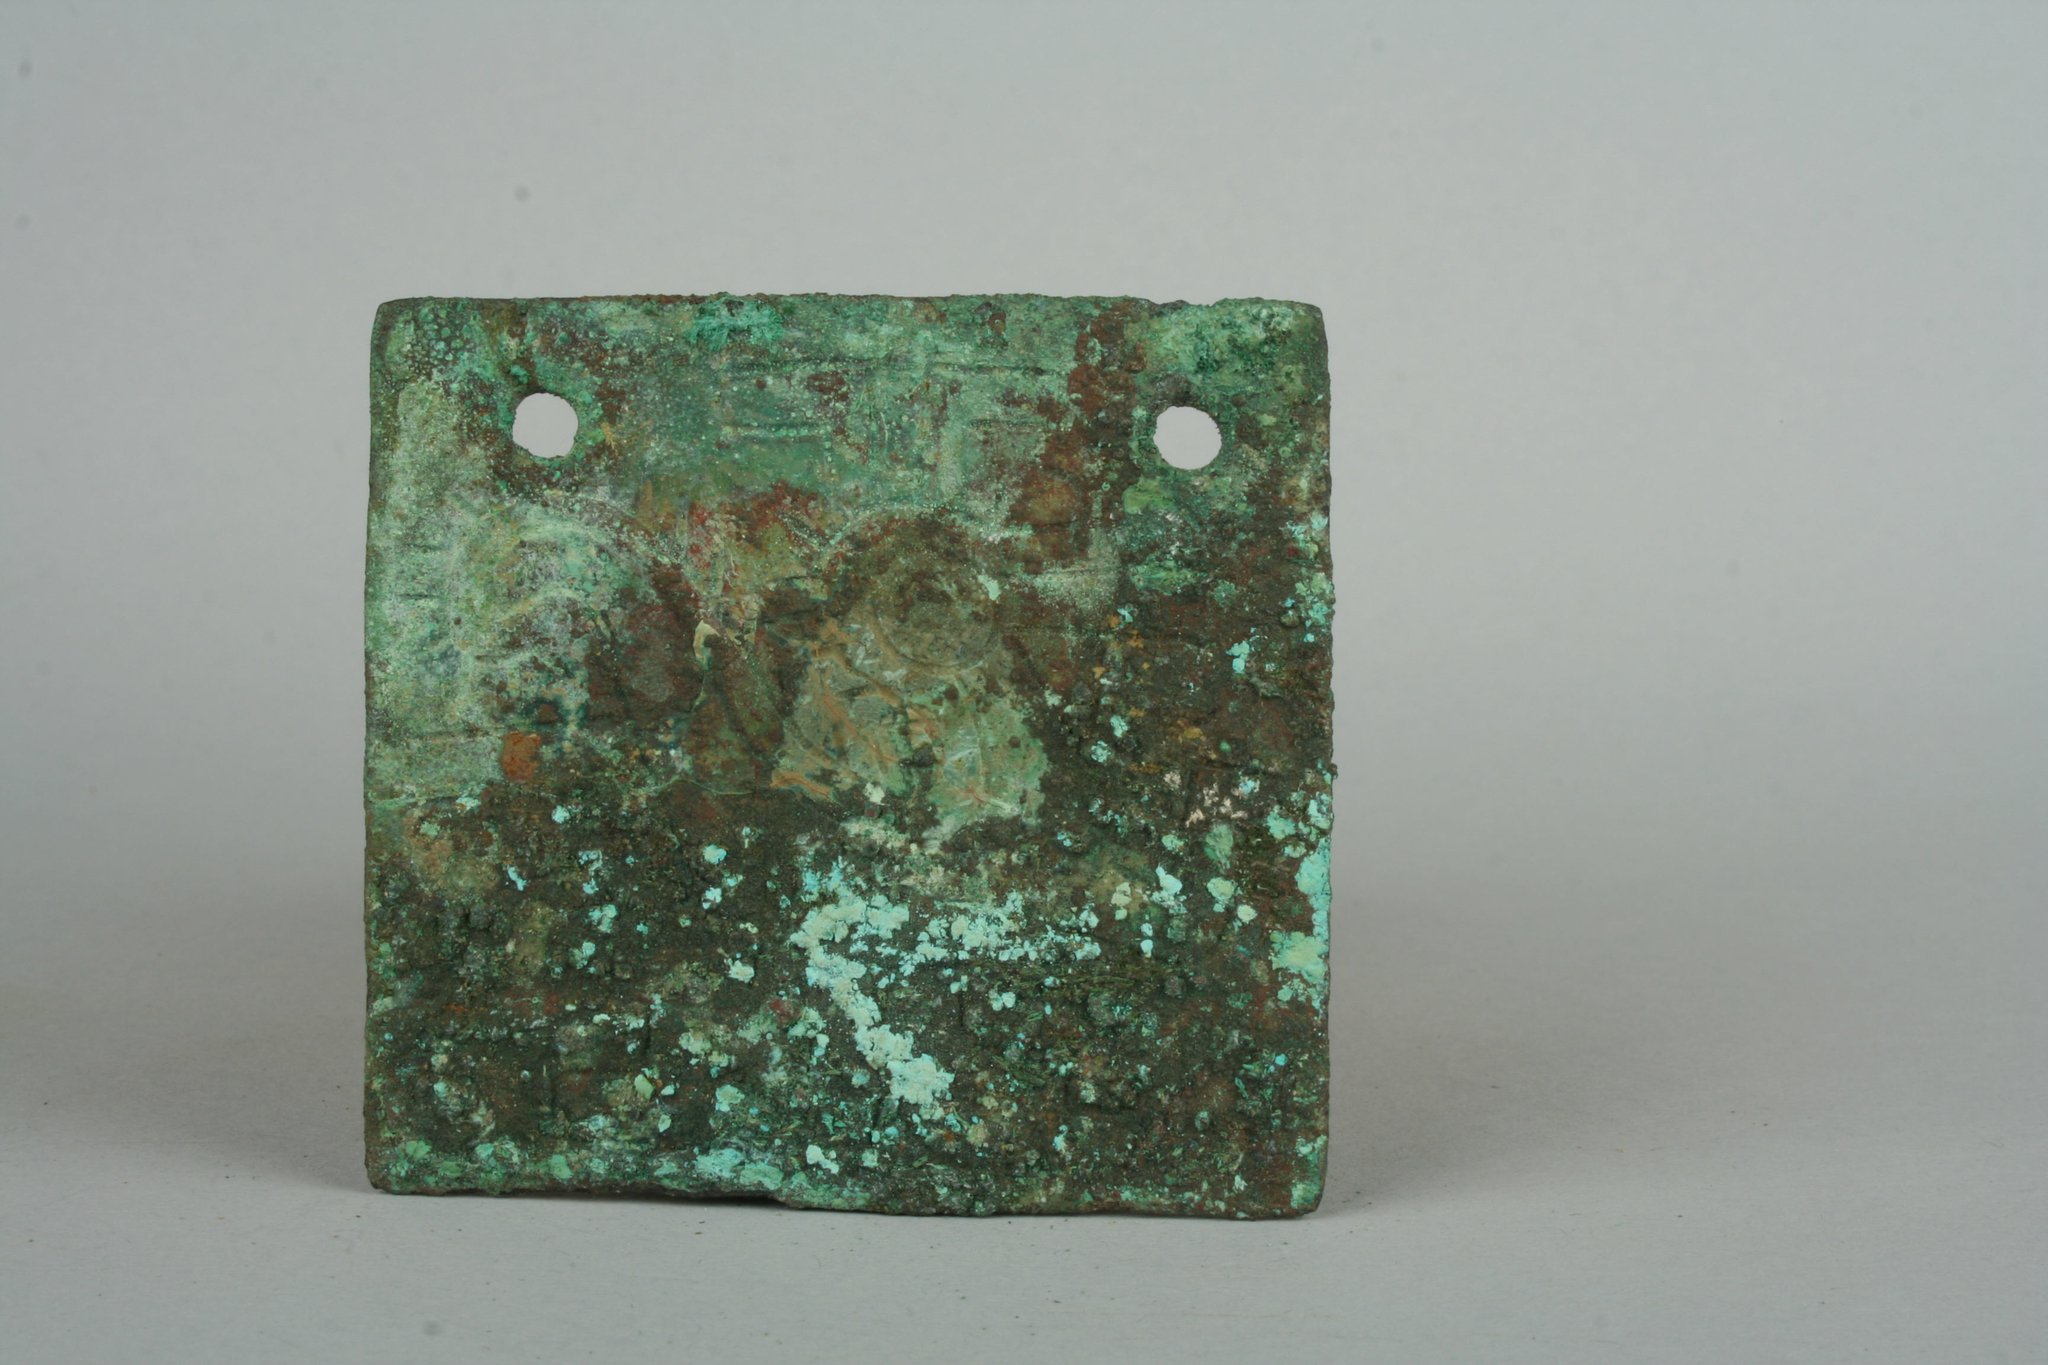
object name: ornament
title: Bird Plaque Ornament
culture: vicús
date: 300 BCE-200 CE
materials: copper, gilt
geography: peru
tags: birds